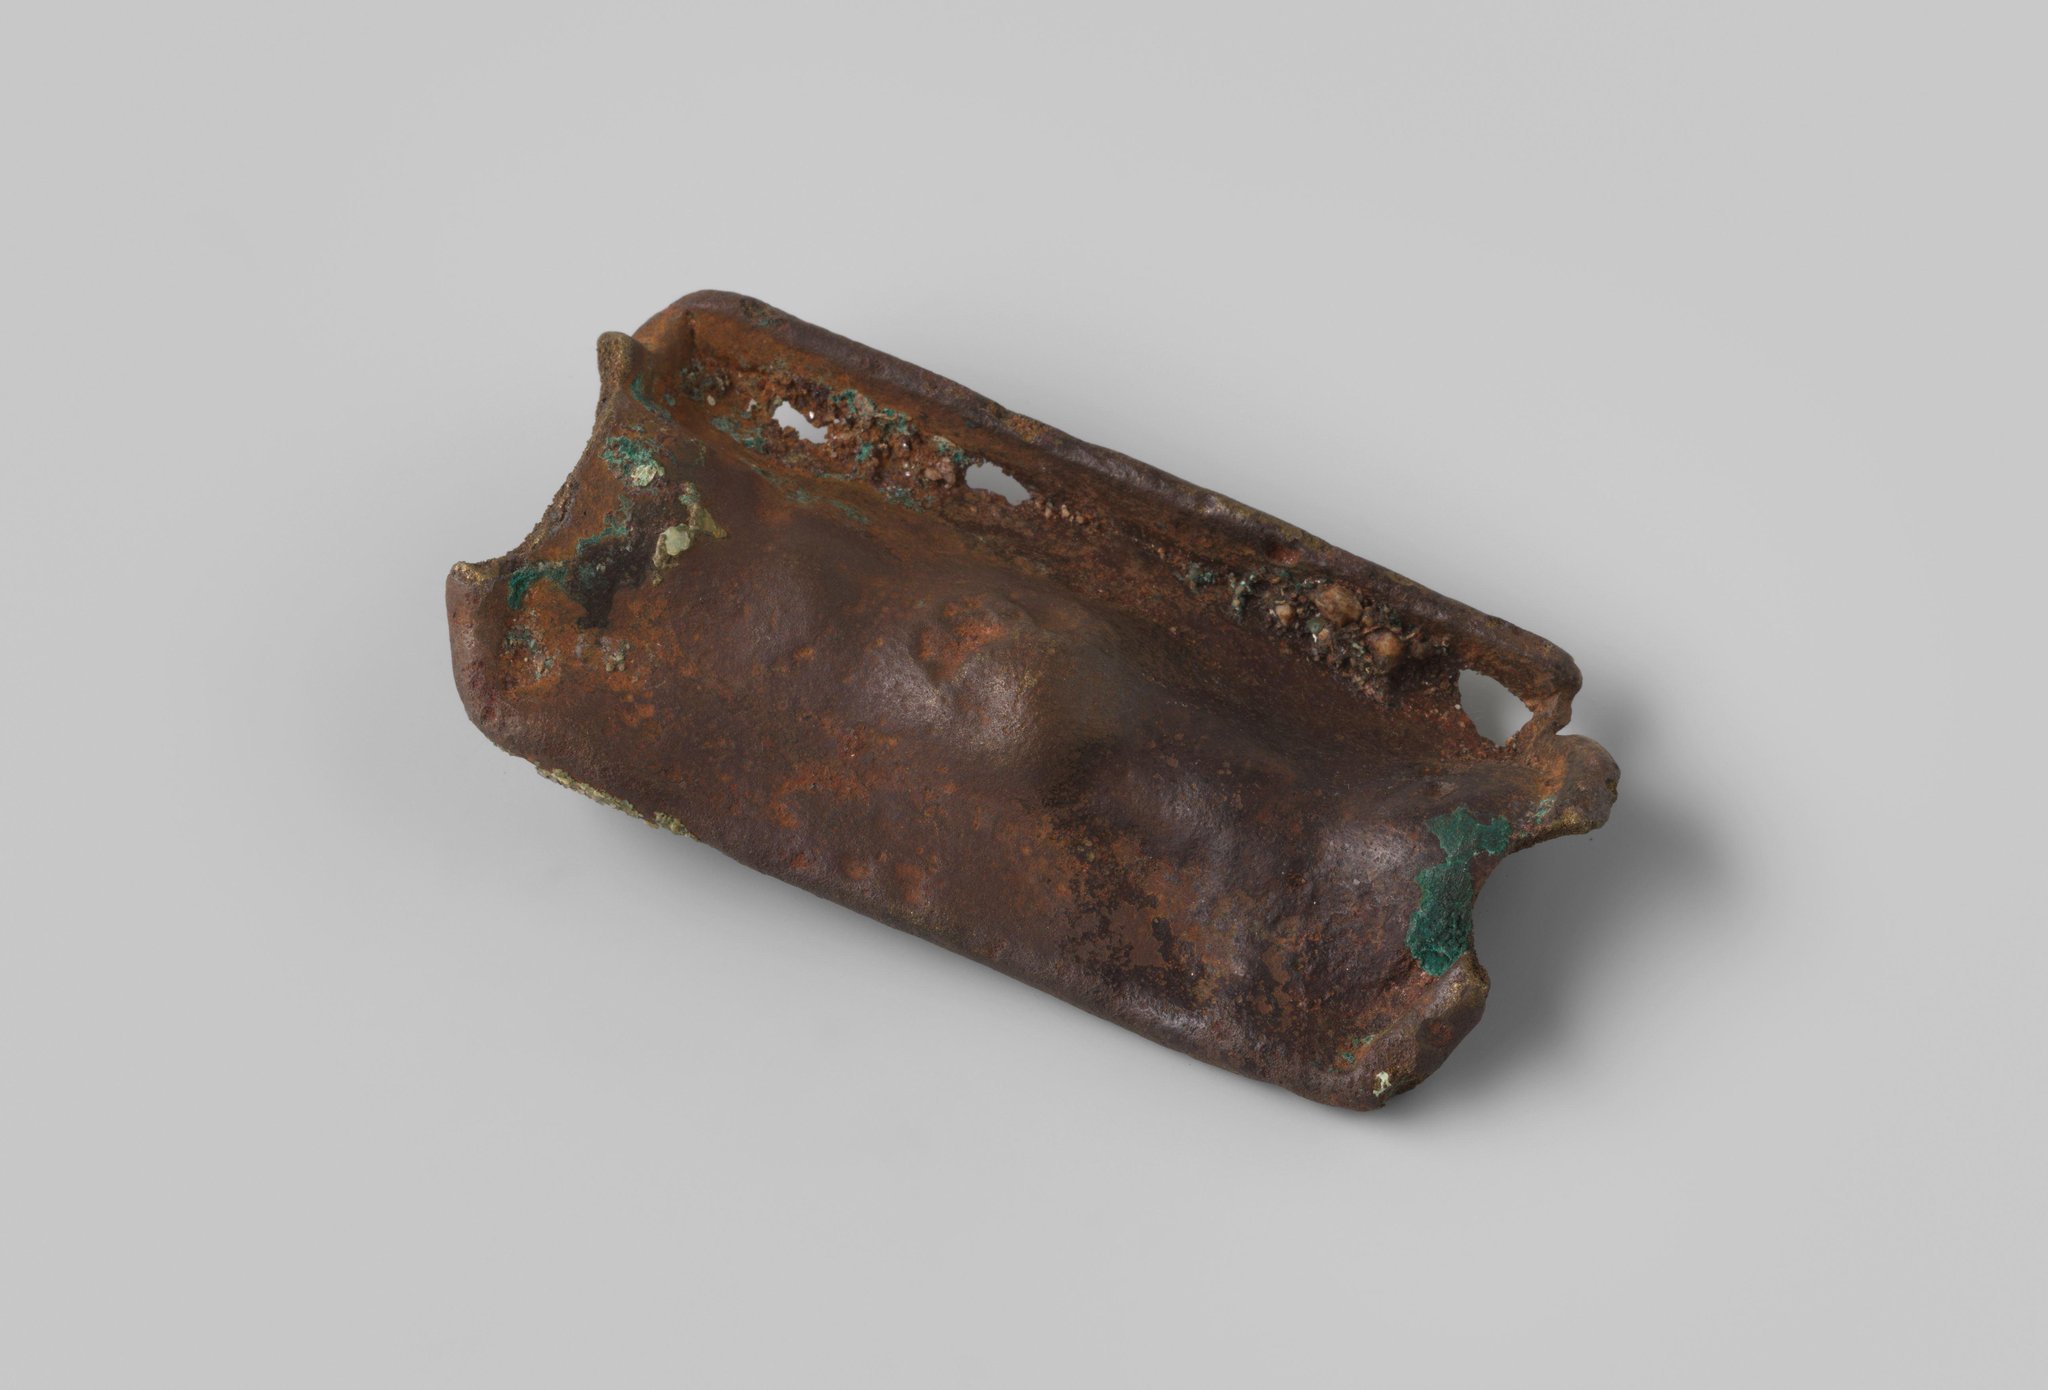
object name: flask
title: Gietmal uit het wrak van de Oost-Indiëvaarder Hollandia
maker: Anonymous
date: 1700-1743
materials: copper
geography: netherlands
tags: verenigde oostindische compagnie, hollandia (schip), annet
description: Tools and instruments, lead casting, mould; countermould of mould NG-1979-168-H-2785, on the reverse handle fitting id. NG-1979-192-H-3074.